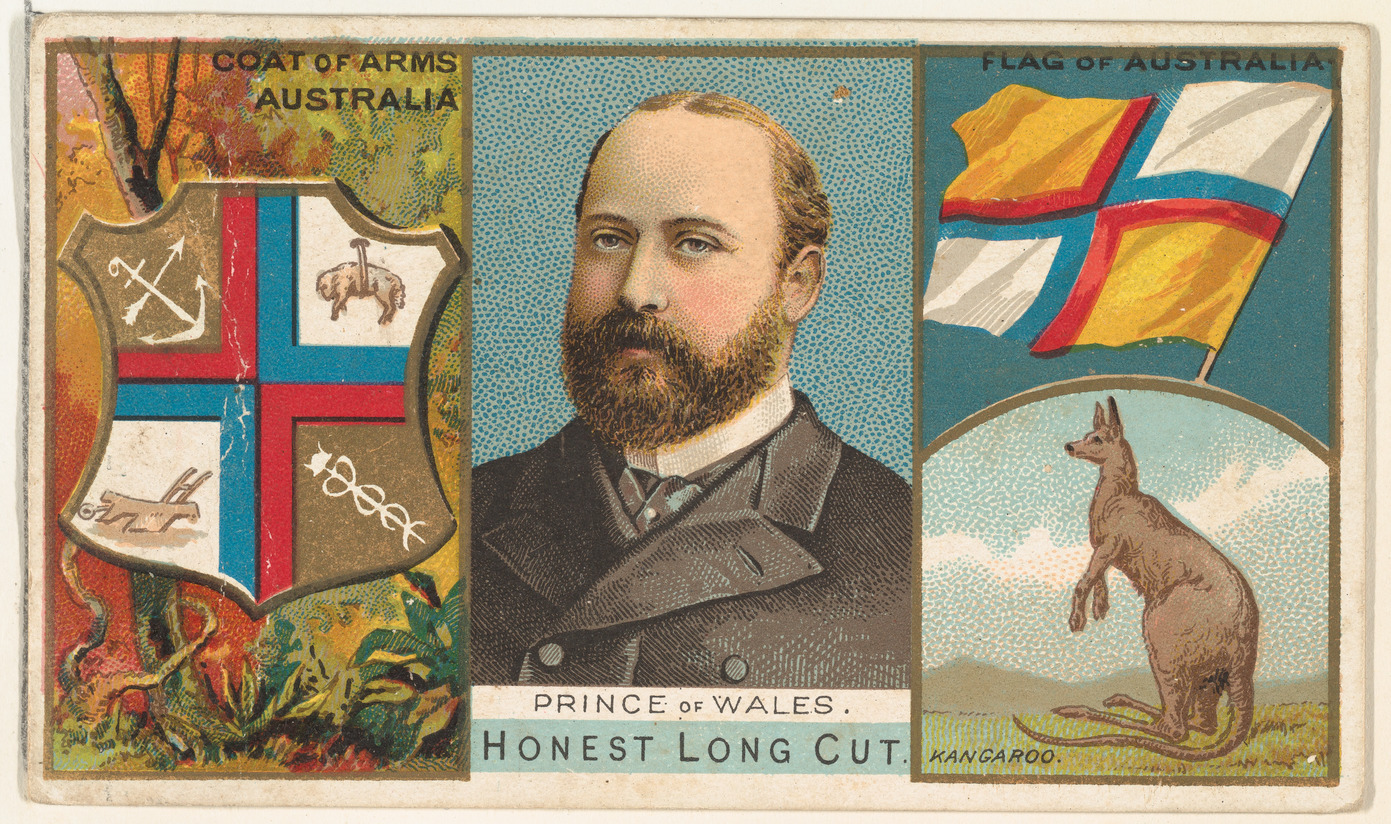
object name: print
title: Prince of Wales, Australia, from the Rulers, Flags, and Coats of Arms series (N126-1) issued by W. Duke, Sons & Co.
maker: w. duke, sons & co.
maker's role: publisher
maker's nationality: american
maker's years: 1870-1920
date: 1888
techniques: color lithograph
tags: animals,princes,portraits,coat of arms,flags